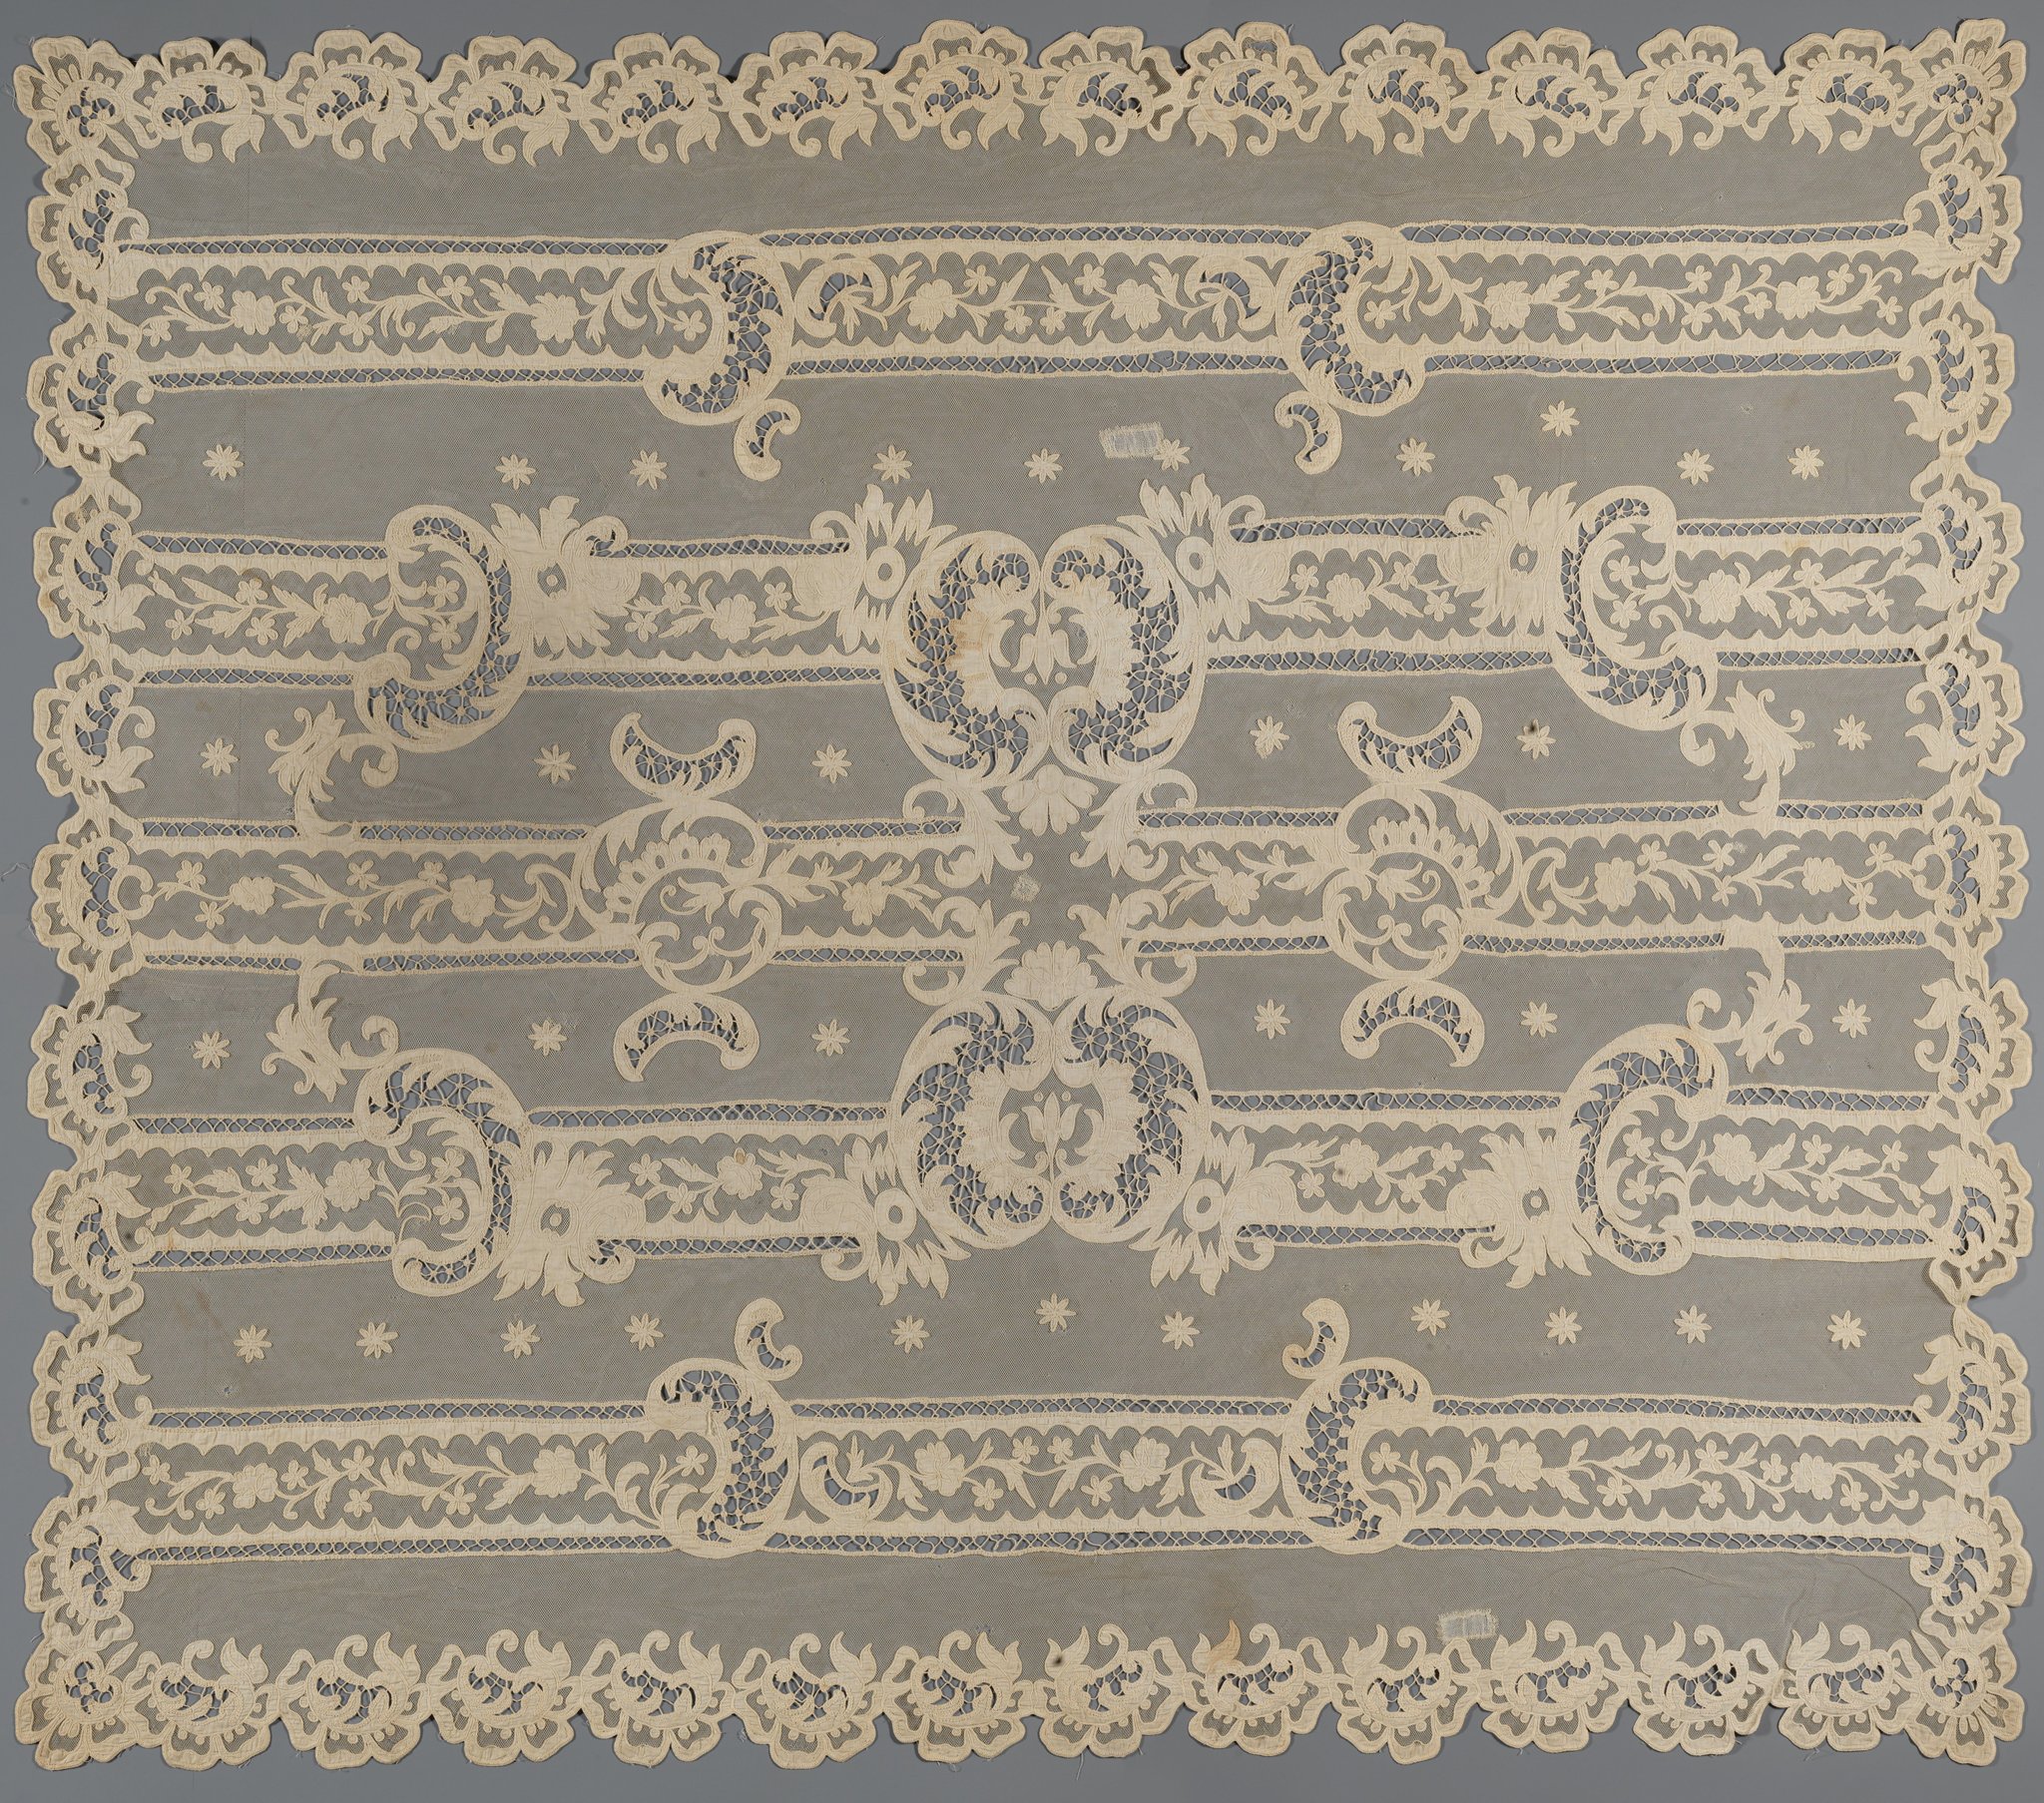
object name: tafelkleed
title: Tafelkleed of sprei van applicatiekant met strepen en bloeiende tak en met oudroze voering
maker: Anonymous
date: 1850-1874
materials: cotton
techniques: lace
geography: belgium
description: Tafelkleed of sprei van applicatiekant. Patroon met vijf staande strepen gevuld met een golvende bloeiende tak, die wordt oversneden door voluten met een rastervulling. Oudroze voering.